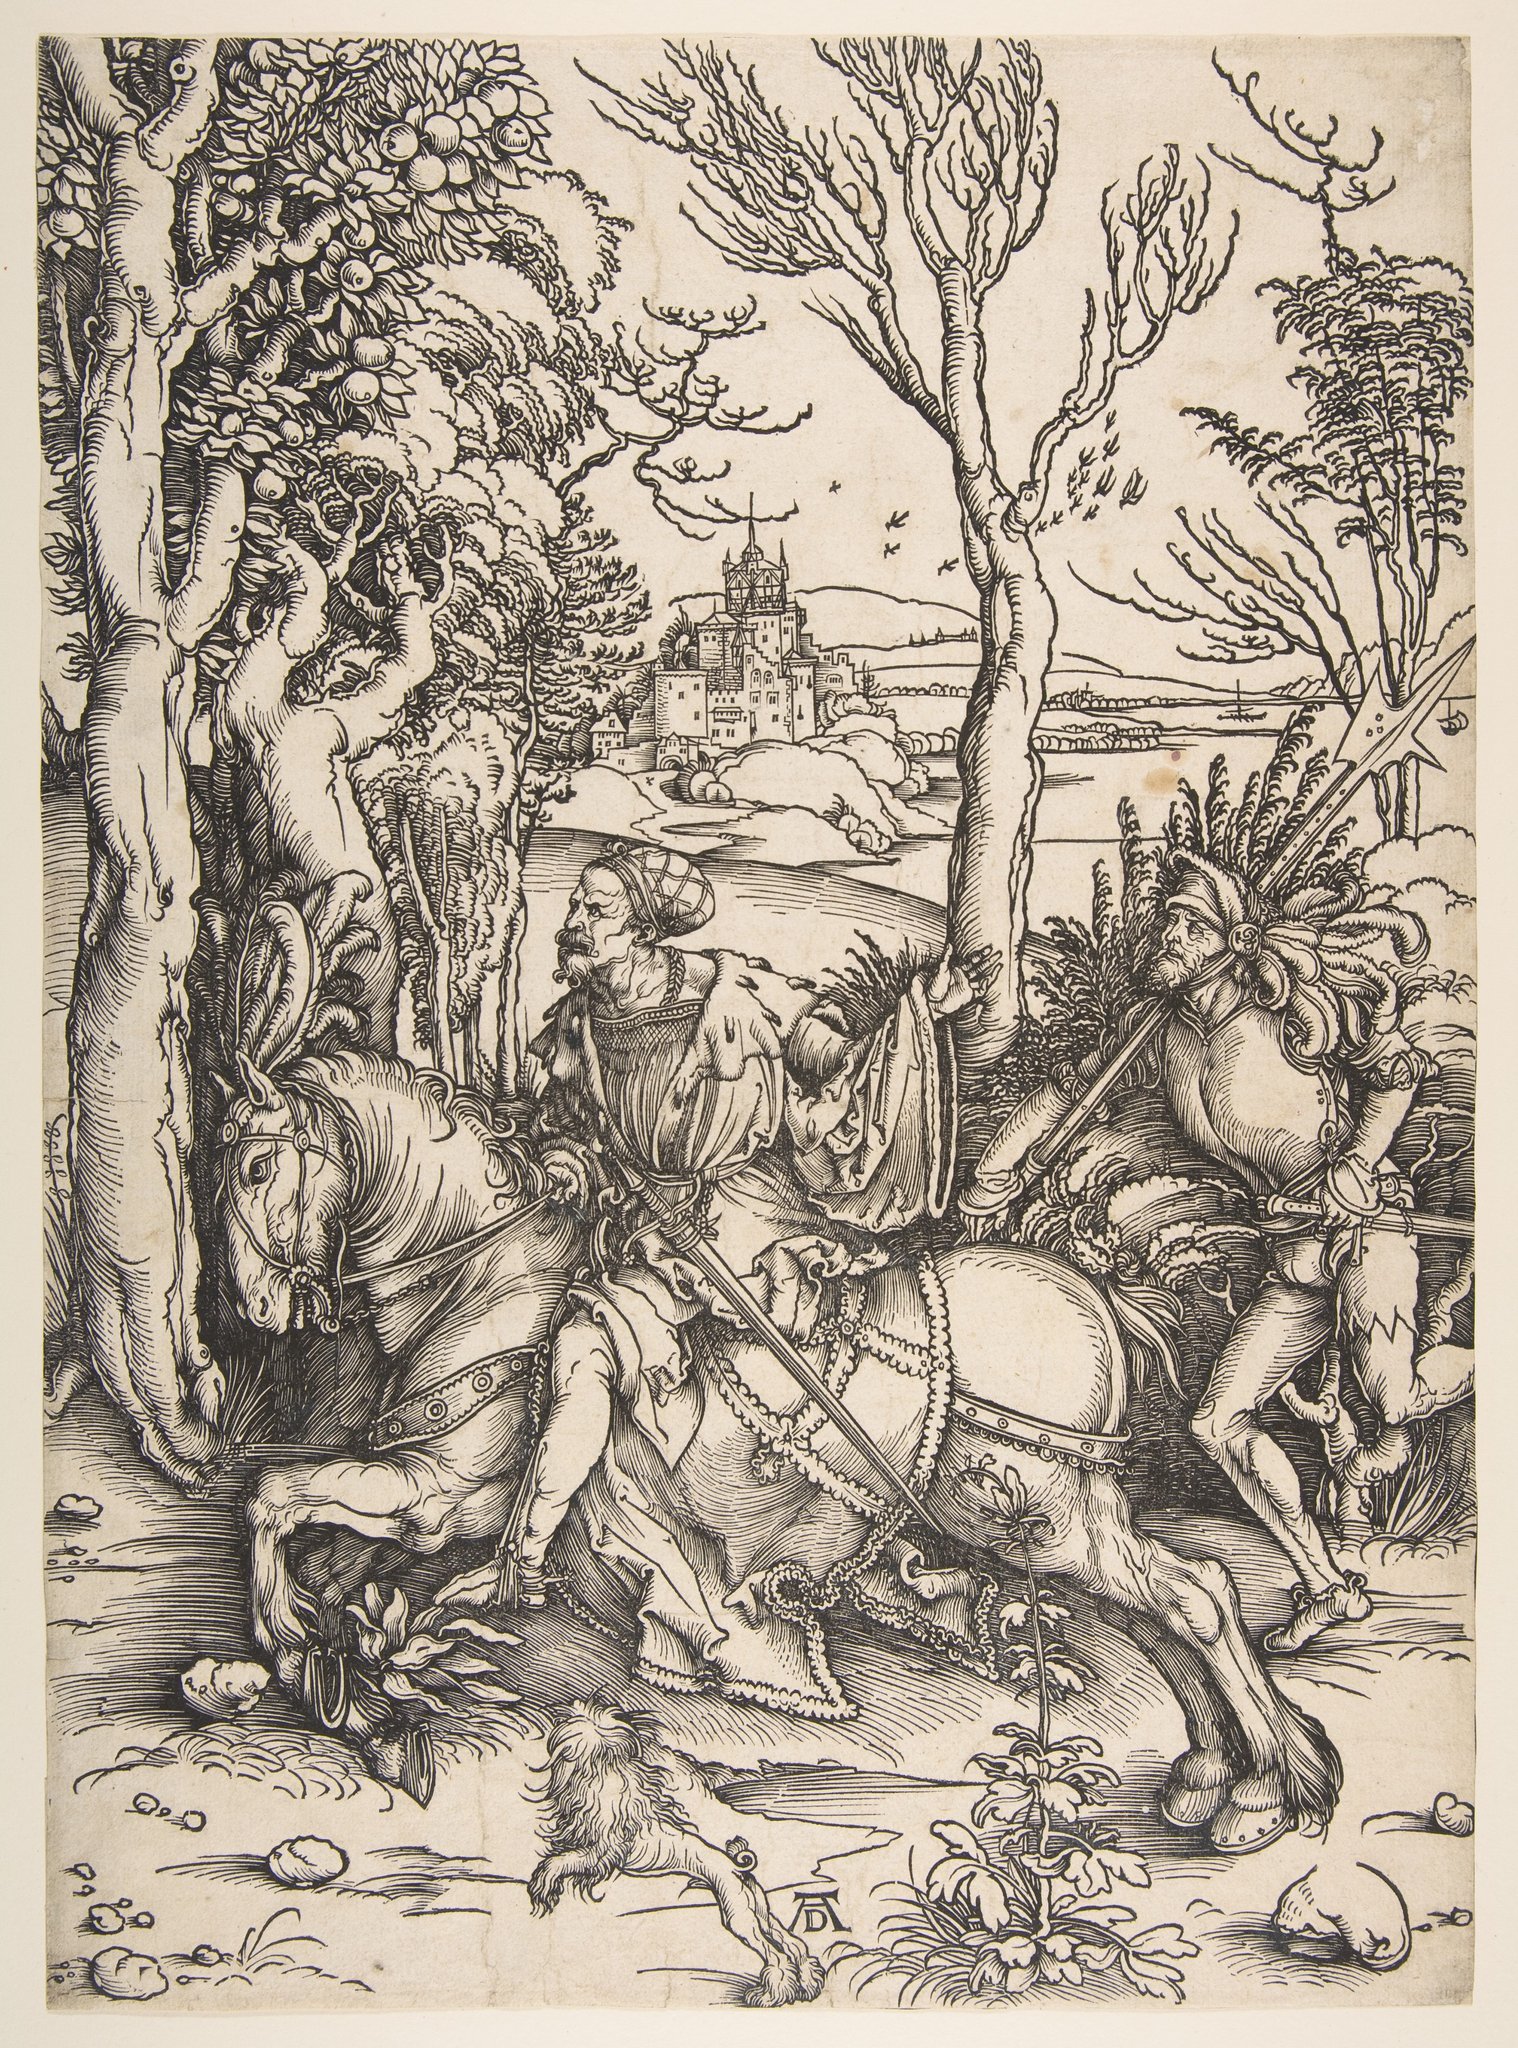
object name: print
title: The Knight and Man-at-arms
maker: albrecht dürer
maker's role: artist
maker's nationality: german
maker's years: 1471-1528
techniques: woodcut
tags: weapons,men,horses,knights